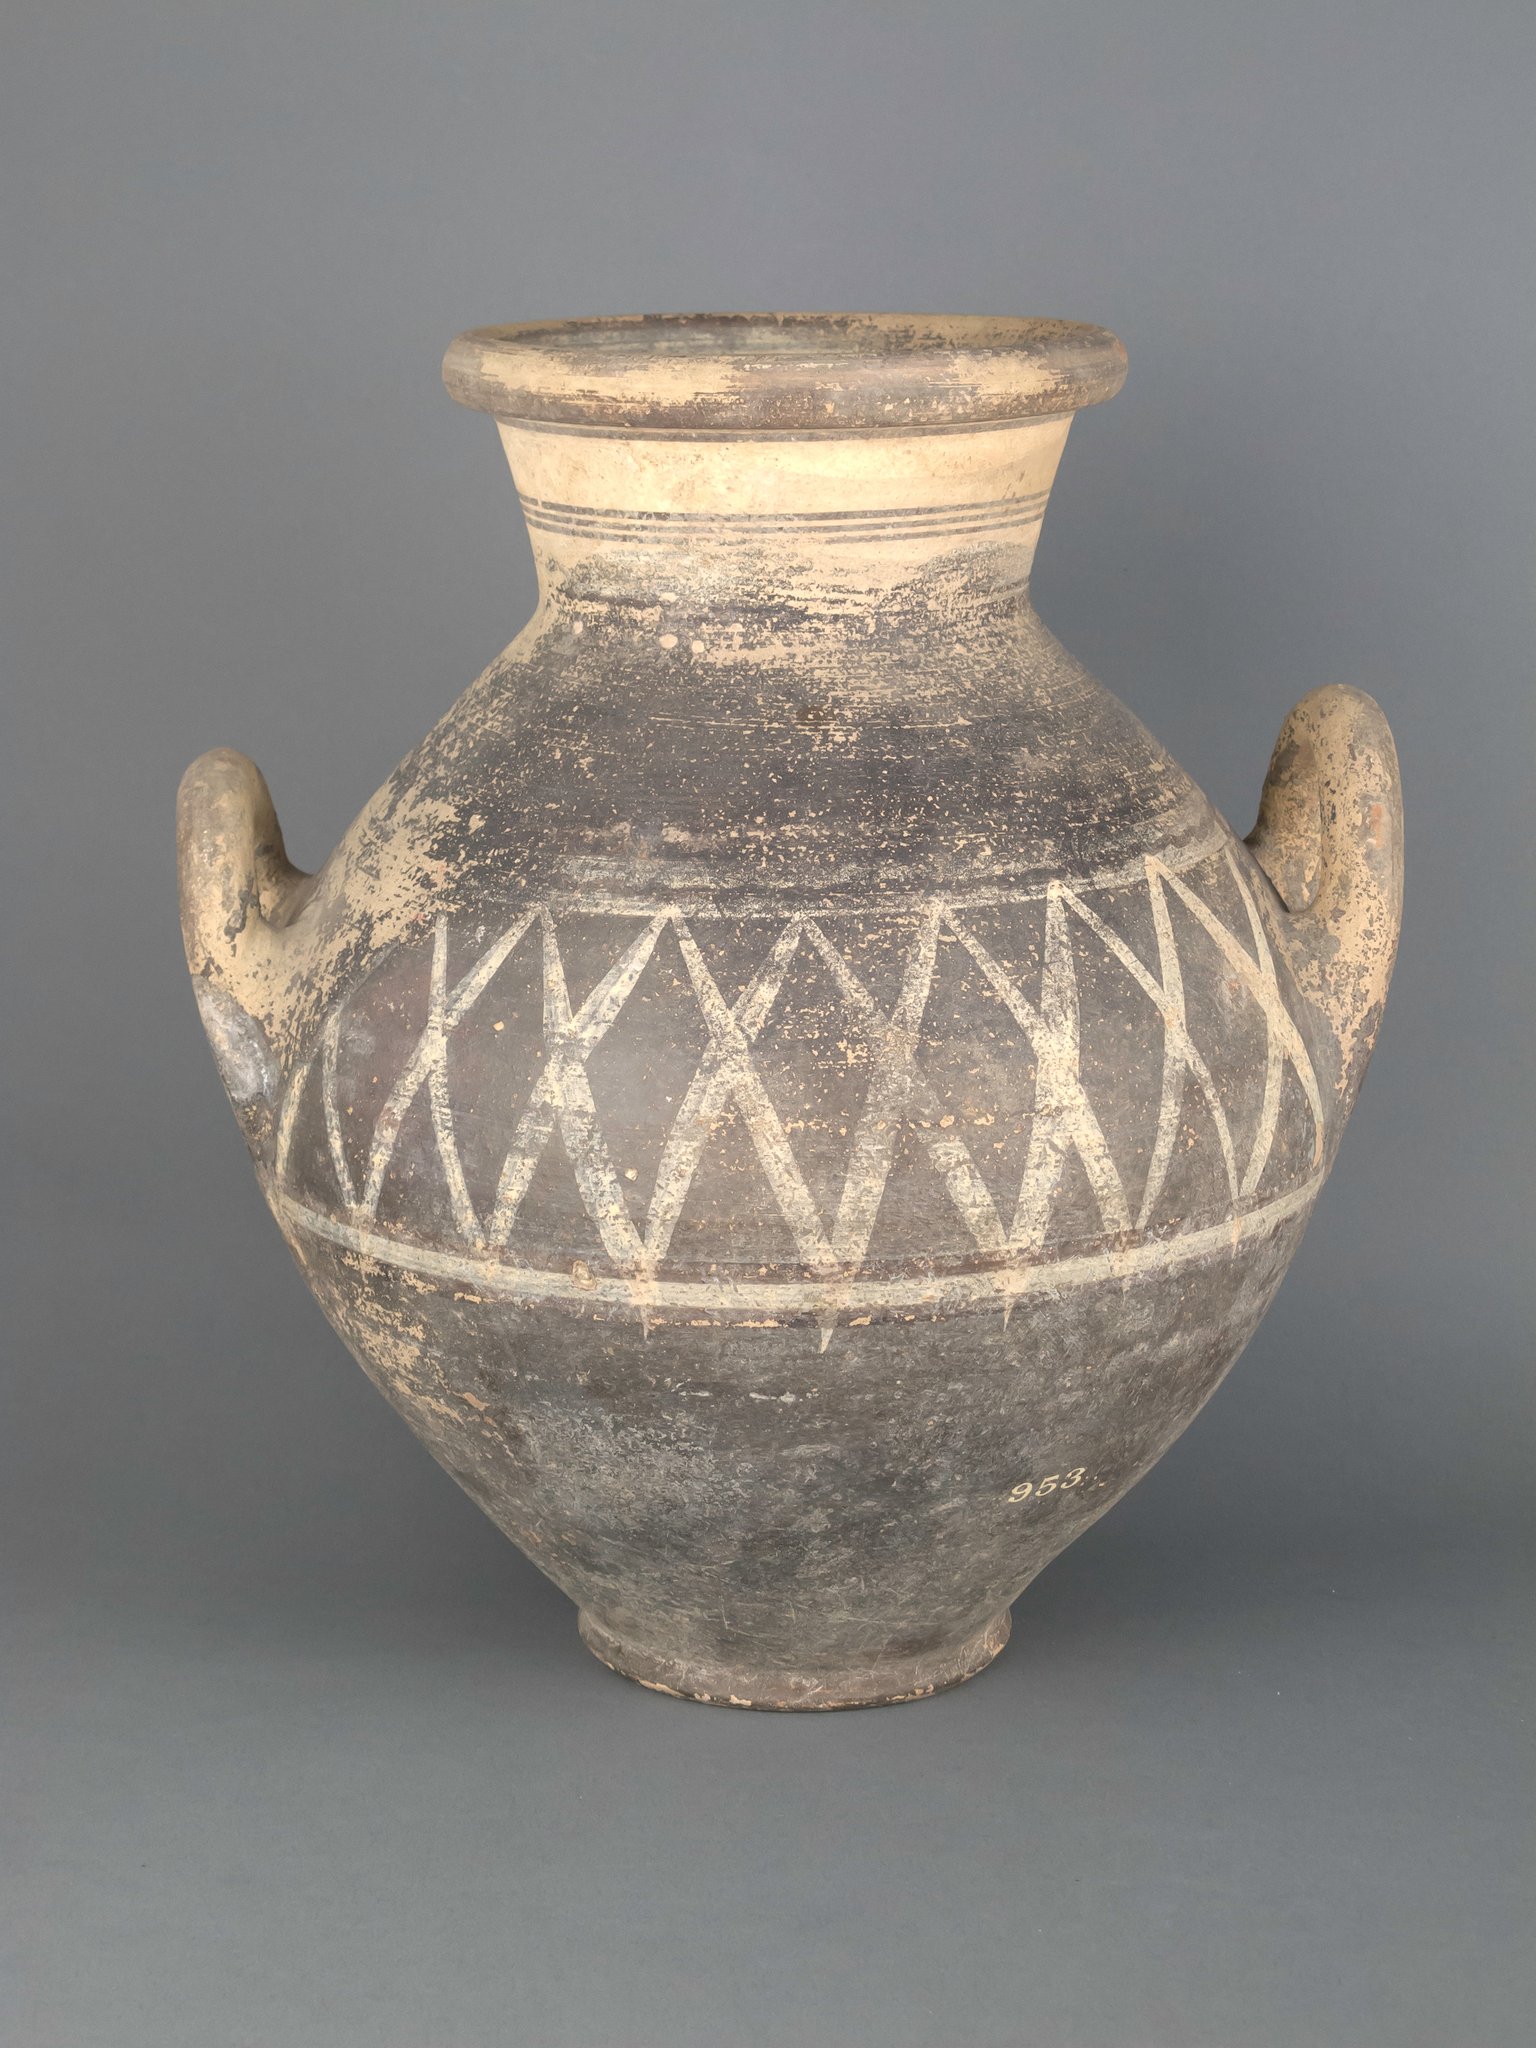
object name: amphora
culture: cypriot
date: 600-480 BCE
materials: terracotta